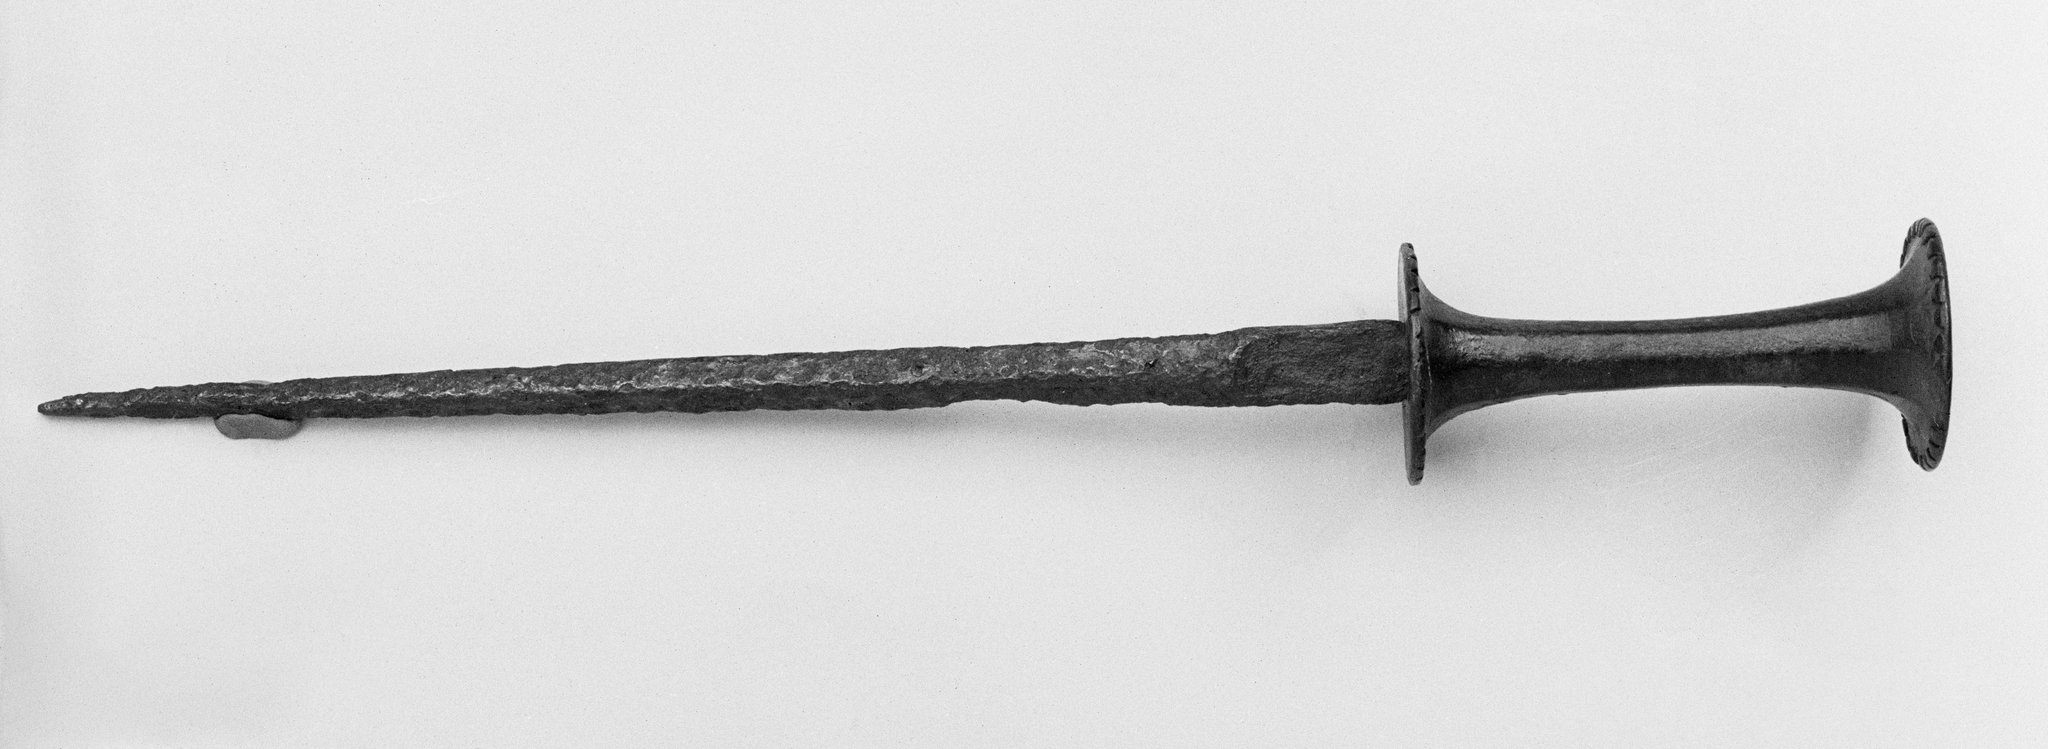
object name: roundel dagger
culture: british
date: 1301-1400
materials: steel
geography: england